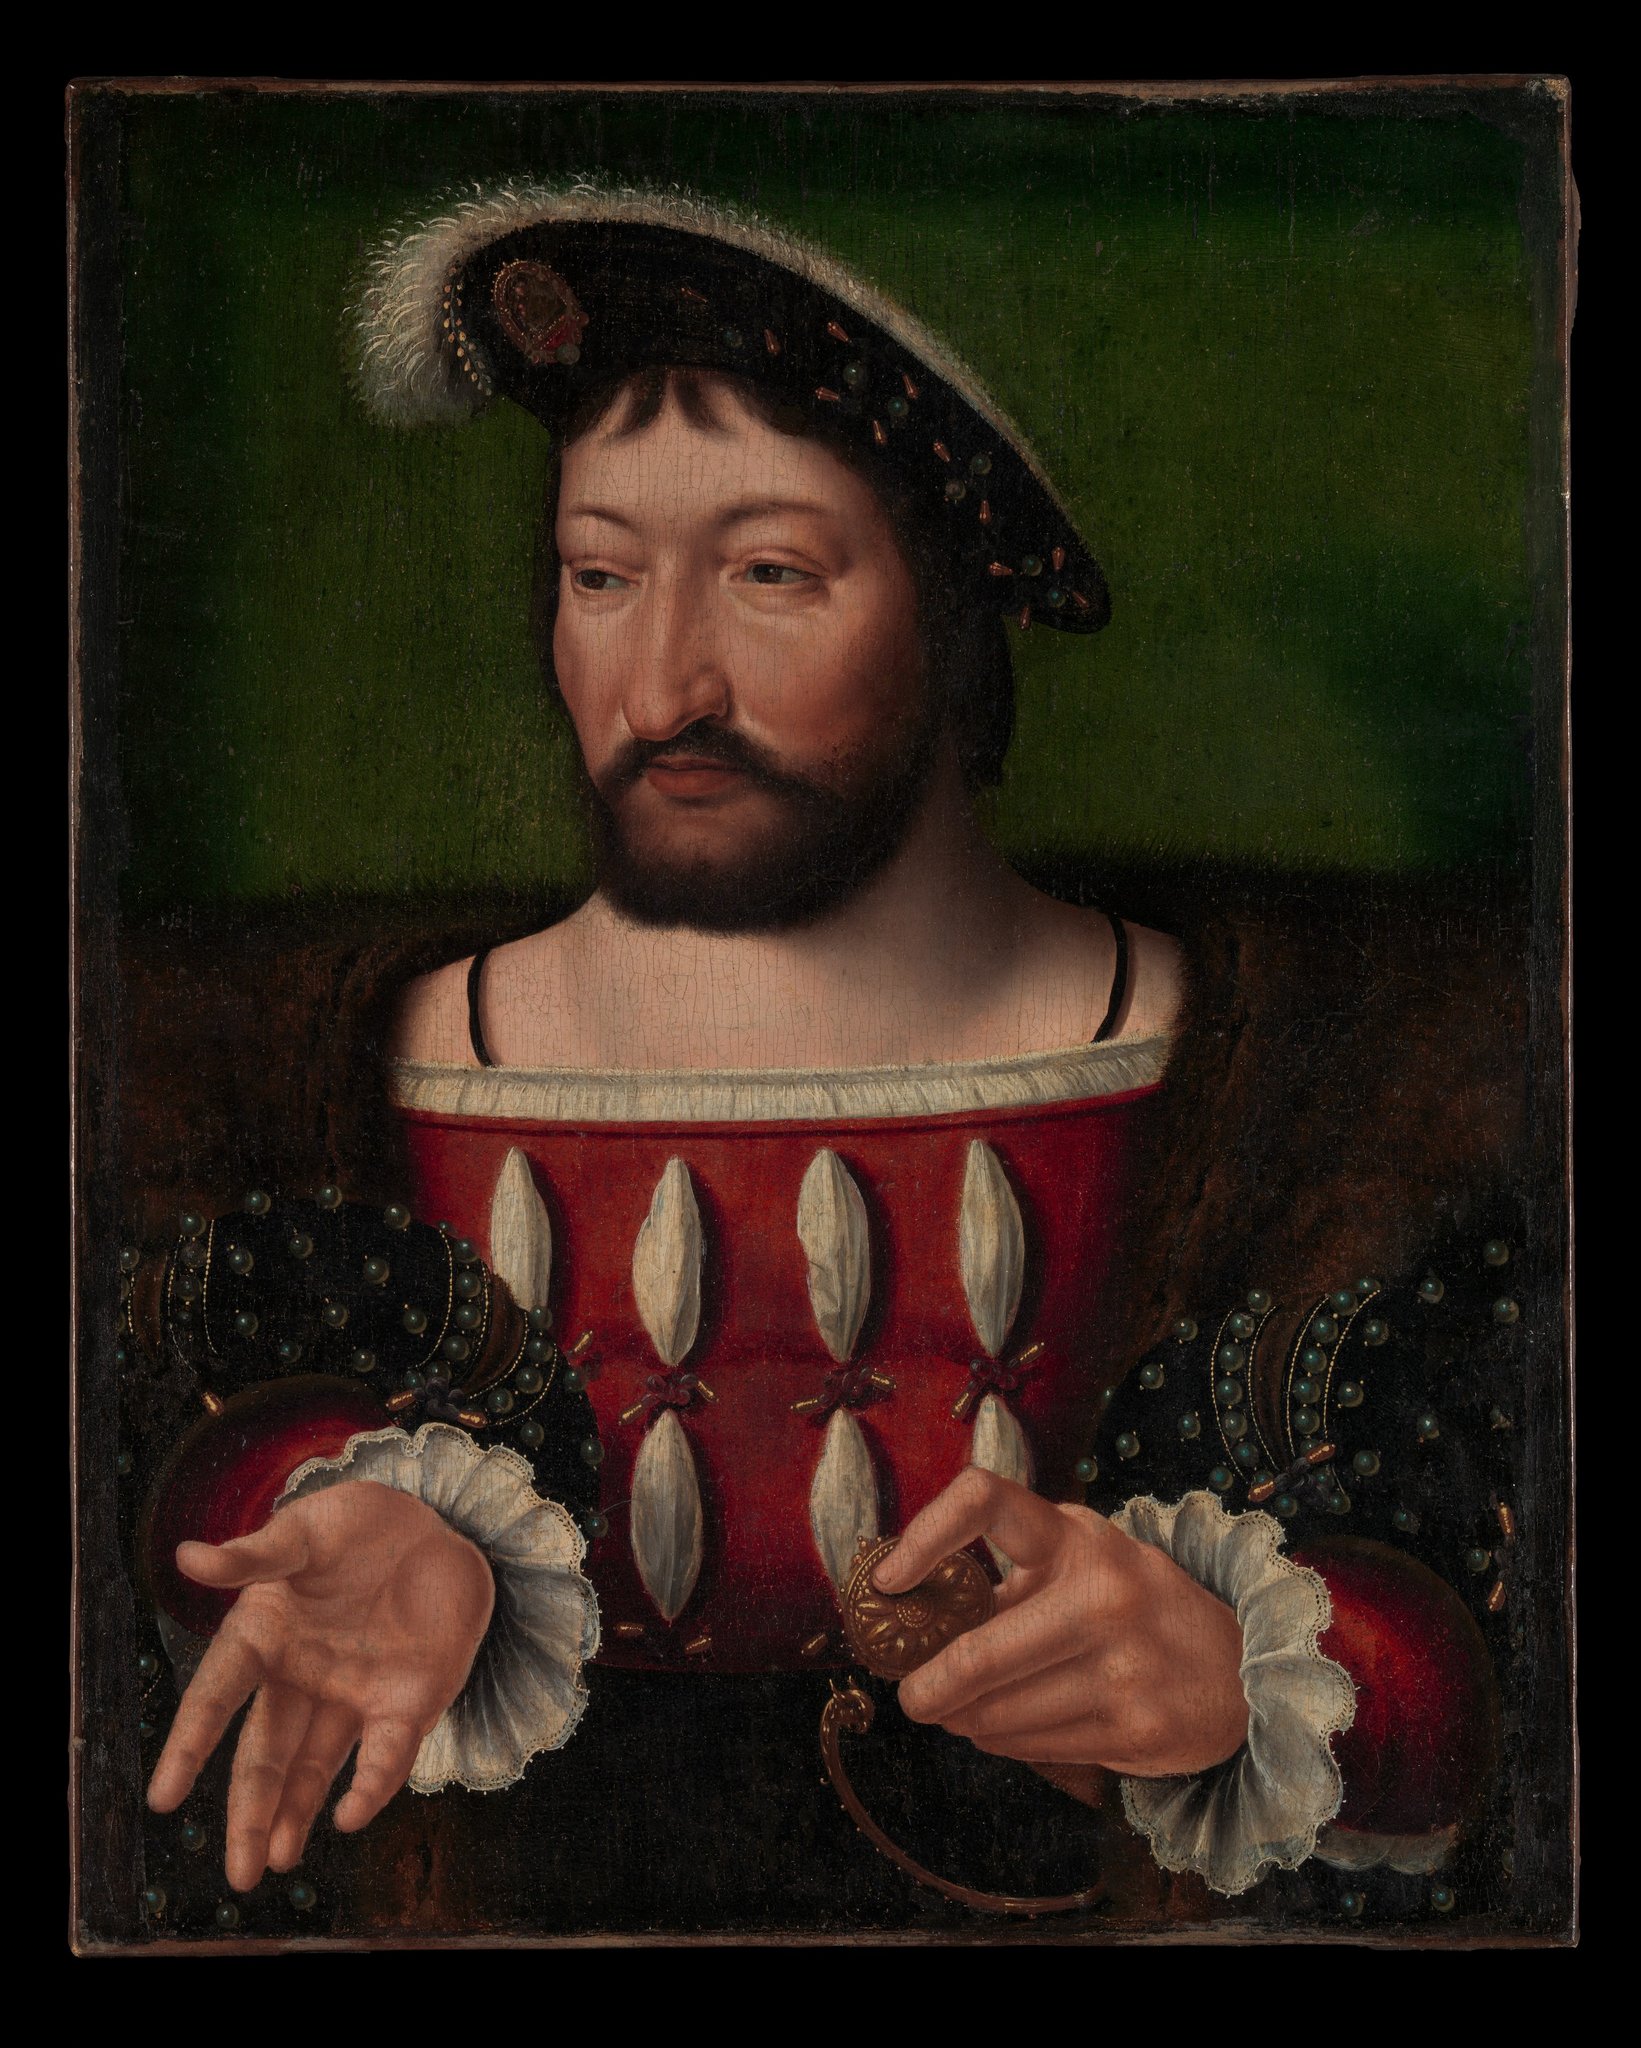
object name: painting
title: Francis I (1494–1547), King of France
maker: joos van cleve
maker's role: artist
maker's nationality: netherlandish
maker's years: 1485-1541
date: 1507-1541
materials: canvas, oil, wood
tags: kings,men,portraits